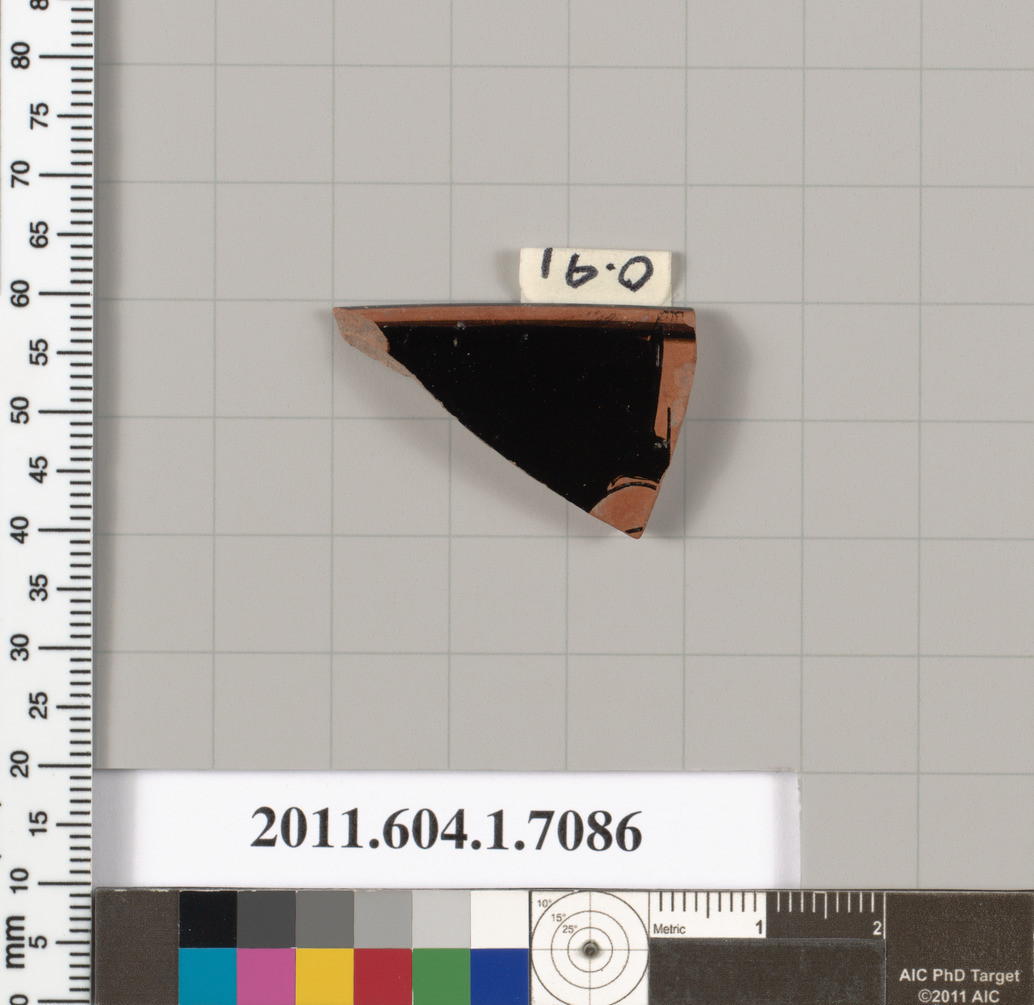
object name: kylix fragment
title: Terracotta rim fragment of a kylix (drinking cup)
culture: greek, attic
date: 500-480 BCE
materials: terracotta